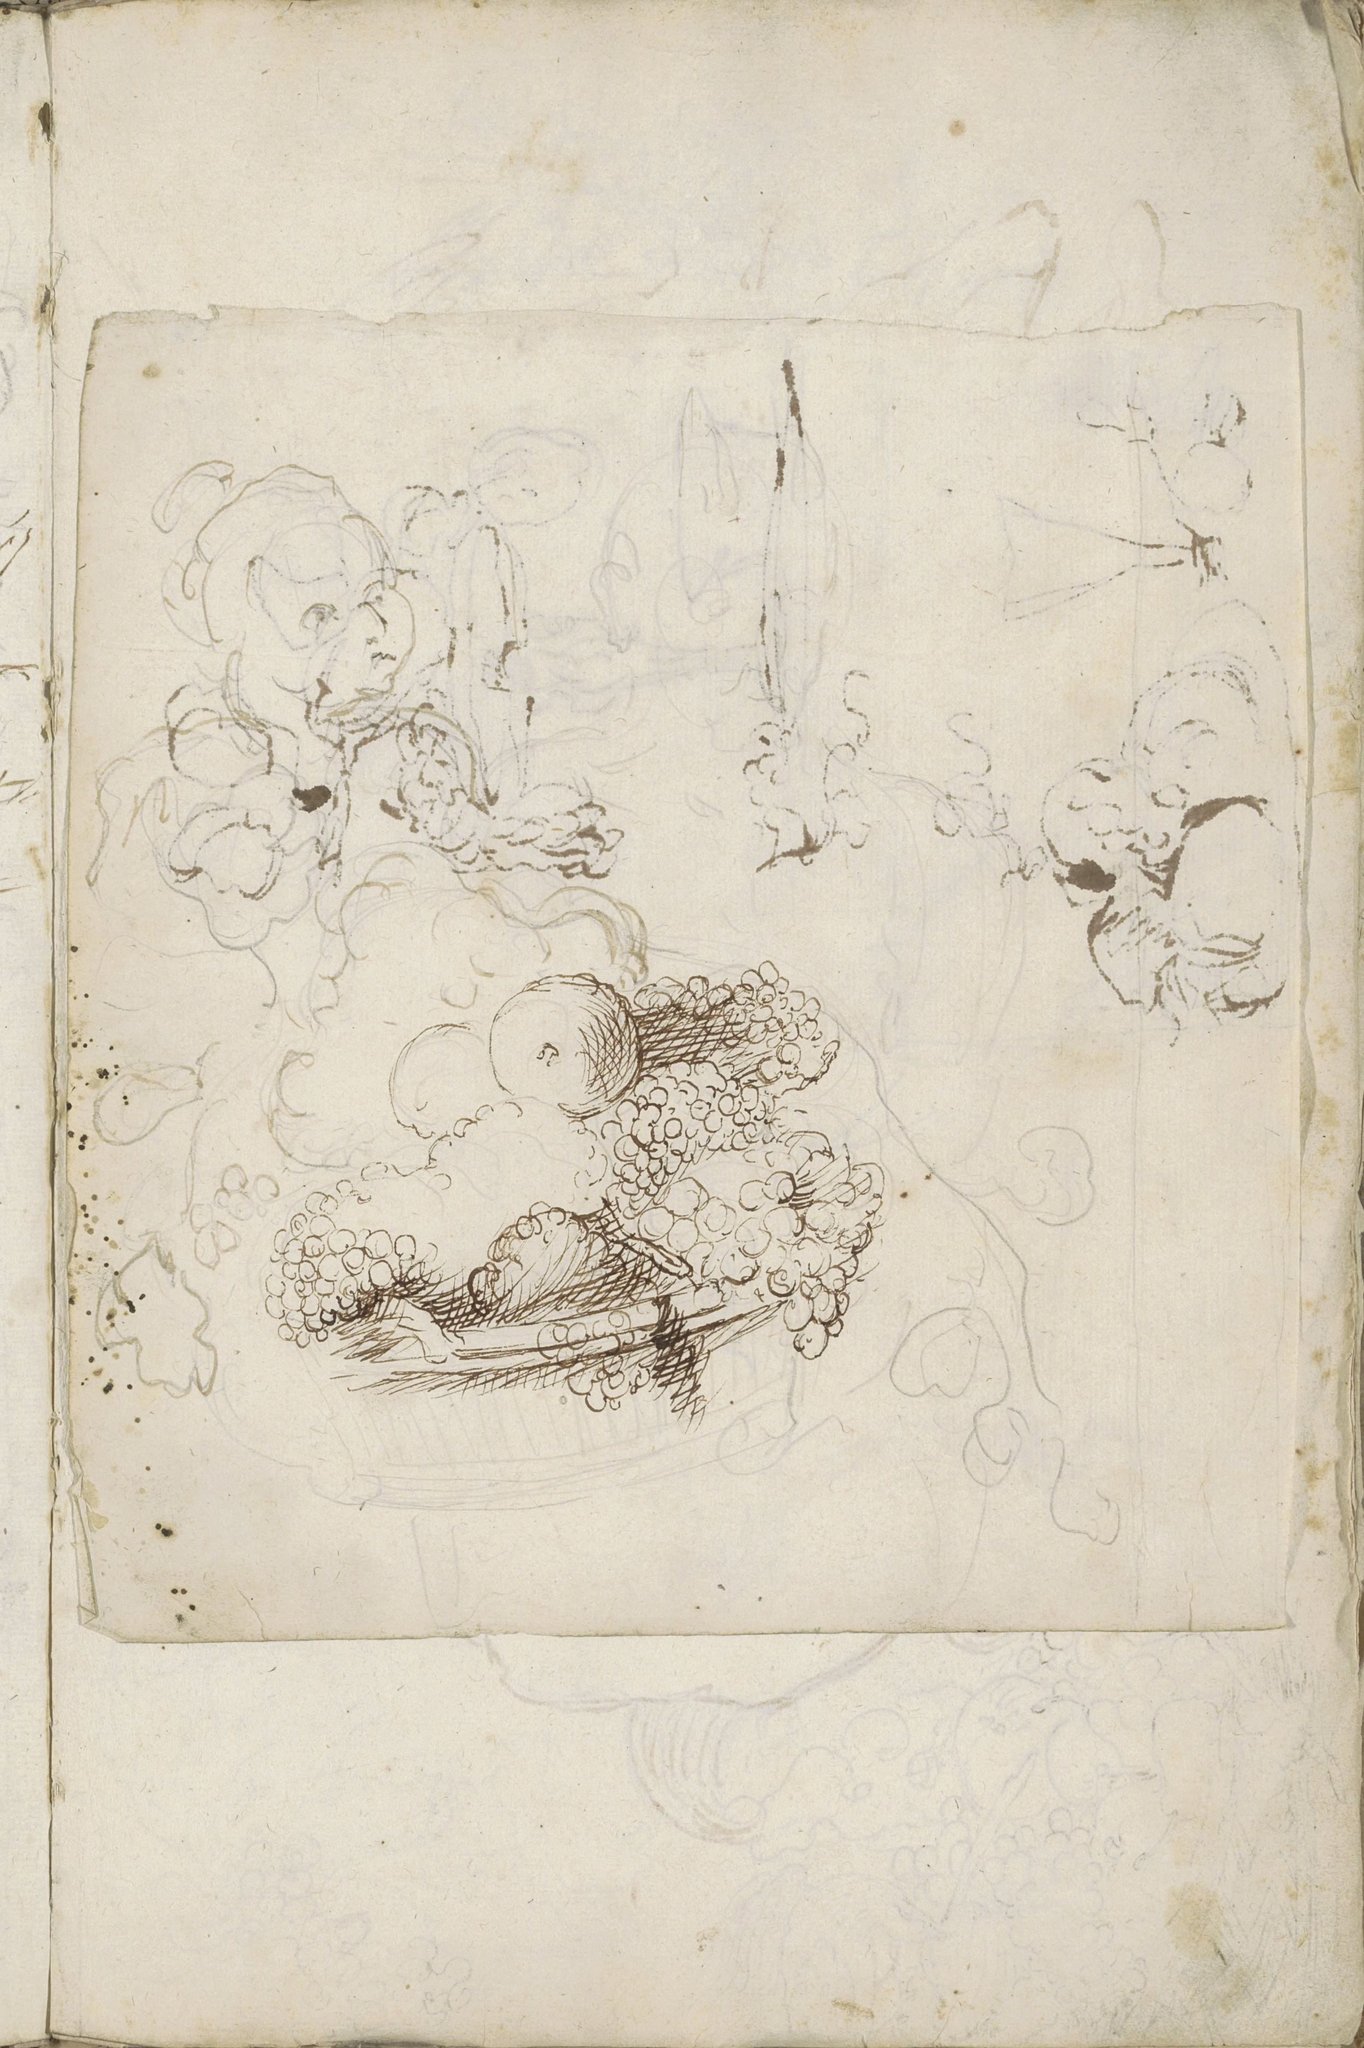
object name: sketchbook leaf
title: Schaal met vruchten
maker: paul de vos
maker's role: draughtsman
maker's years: 1595-1678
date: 1605-1678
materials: ink, paper, pencil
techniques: pen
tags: foodstuffs; still life of foodstuffs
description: Blad 11 recto uit een schetsboek met 15 bladen.